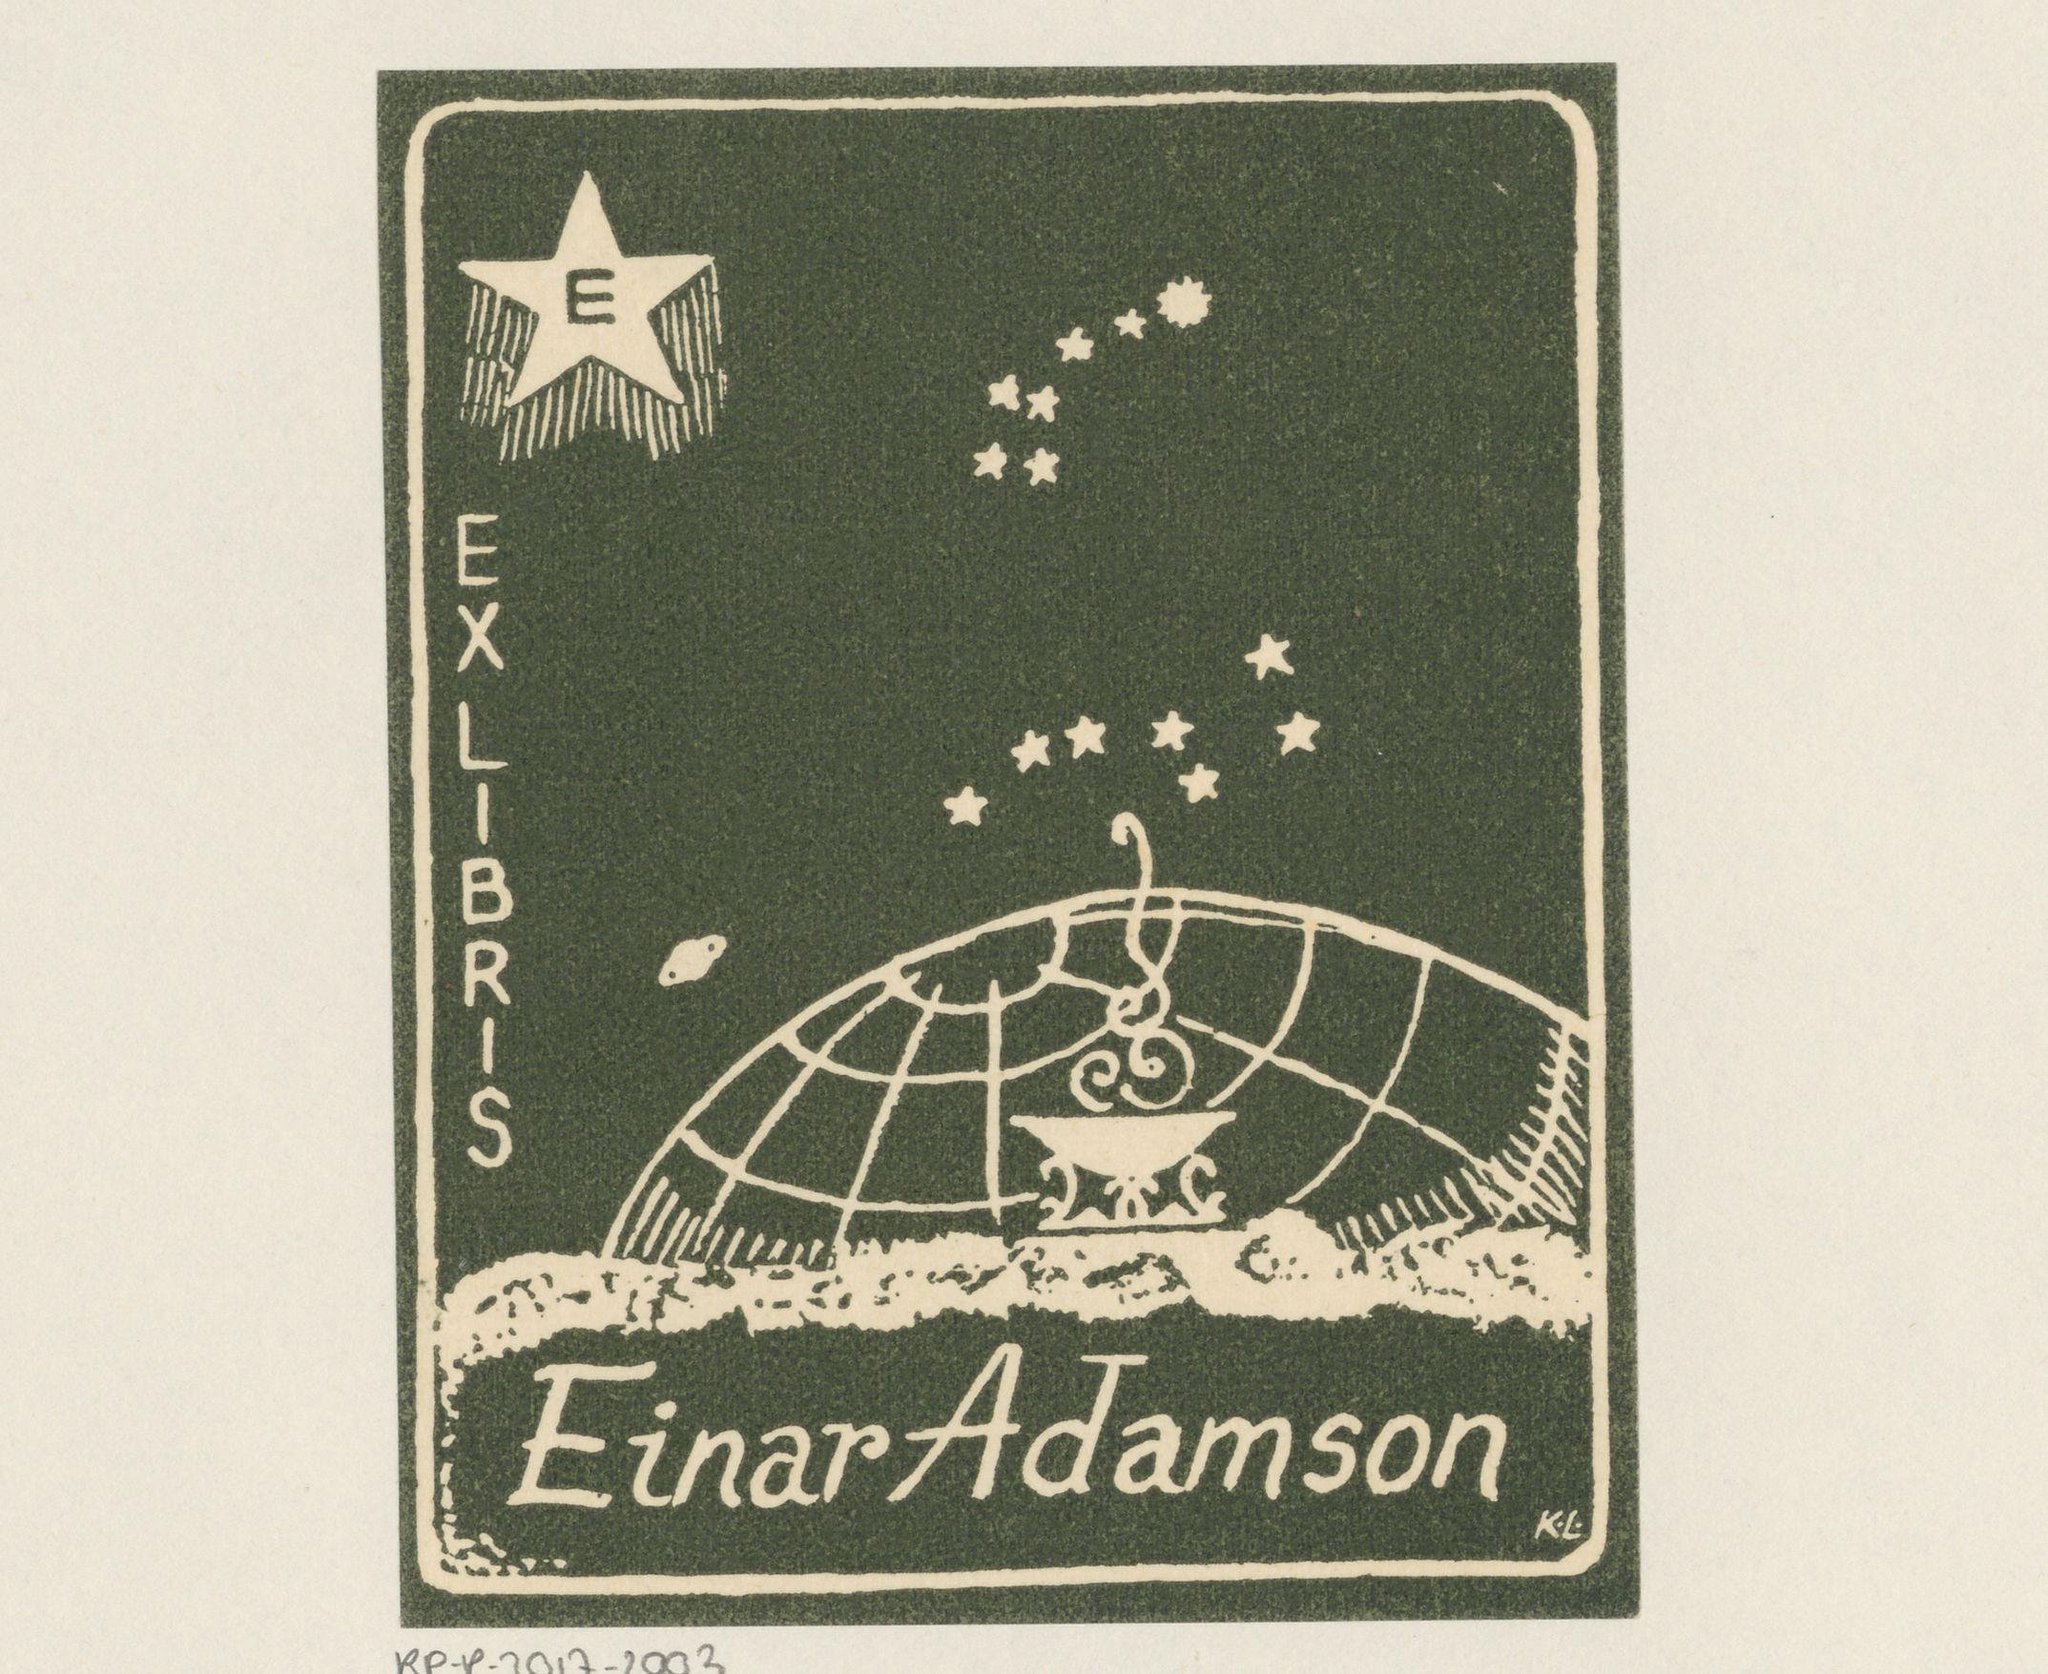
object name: bookplate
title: Ex libris van Einar Adamson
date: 1904-1953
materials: paper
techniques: printing block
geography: sweden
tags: politician, earth, world as celestial body, stars, incense-burner ~ scents, perfumes